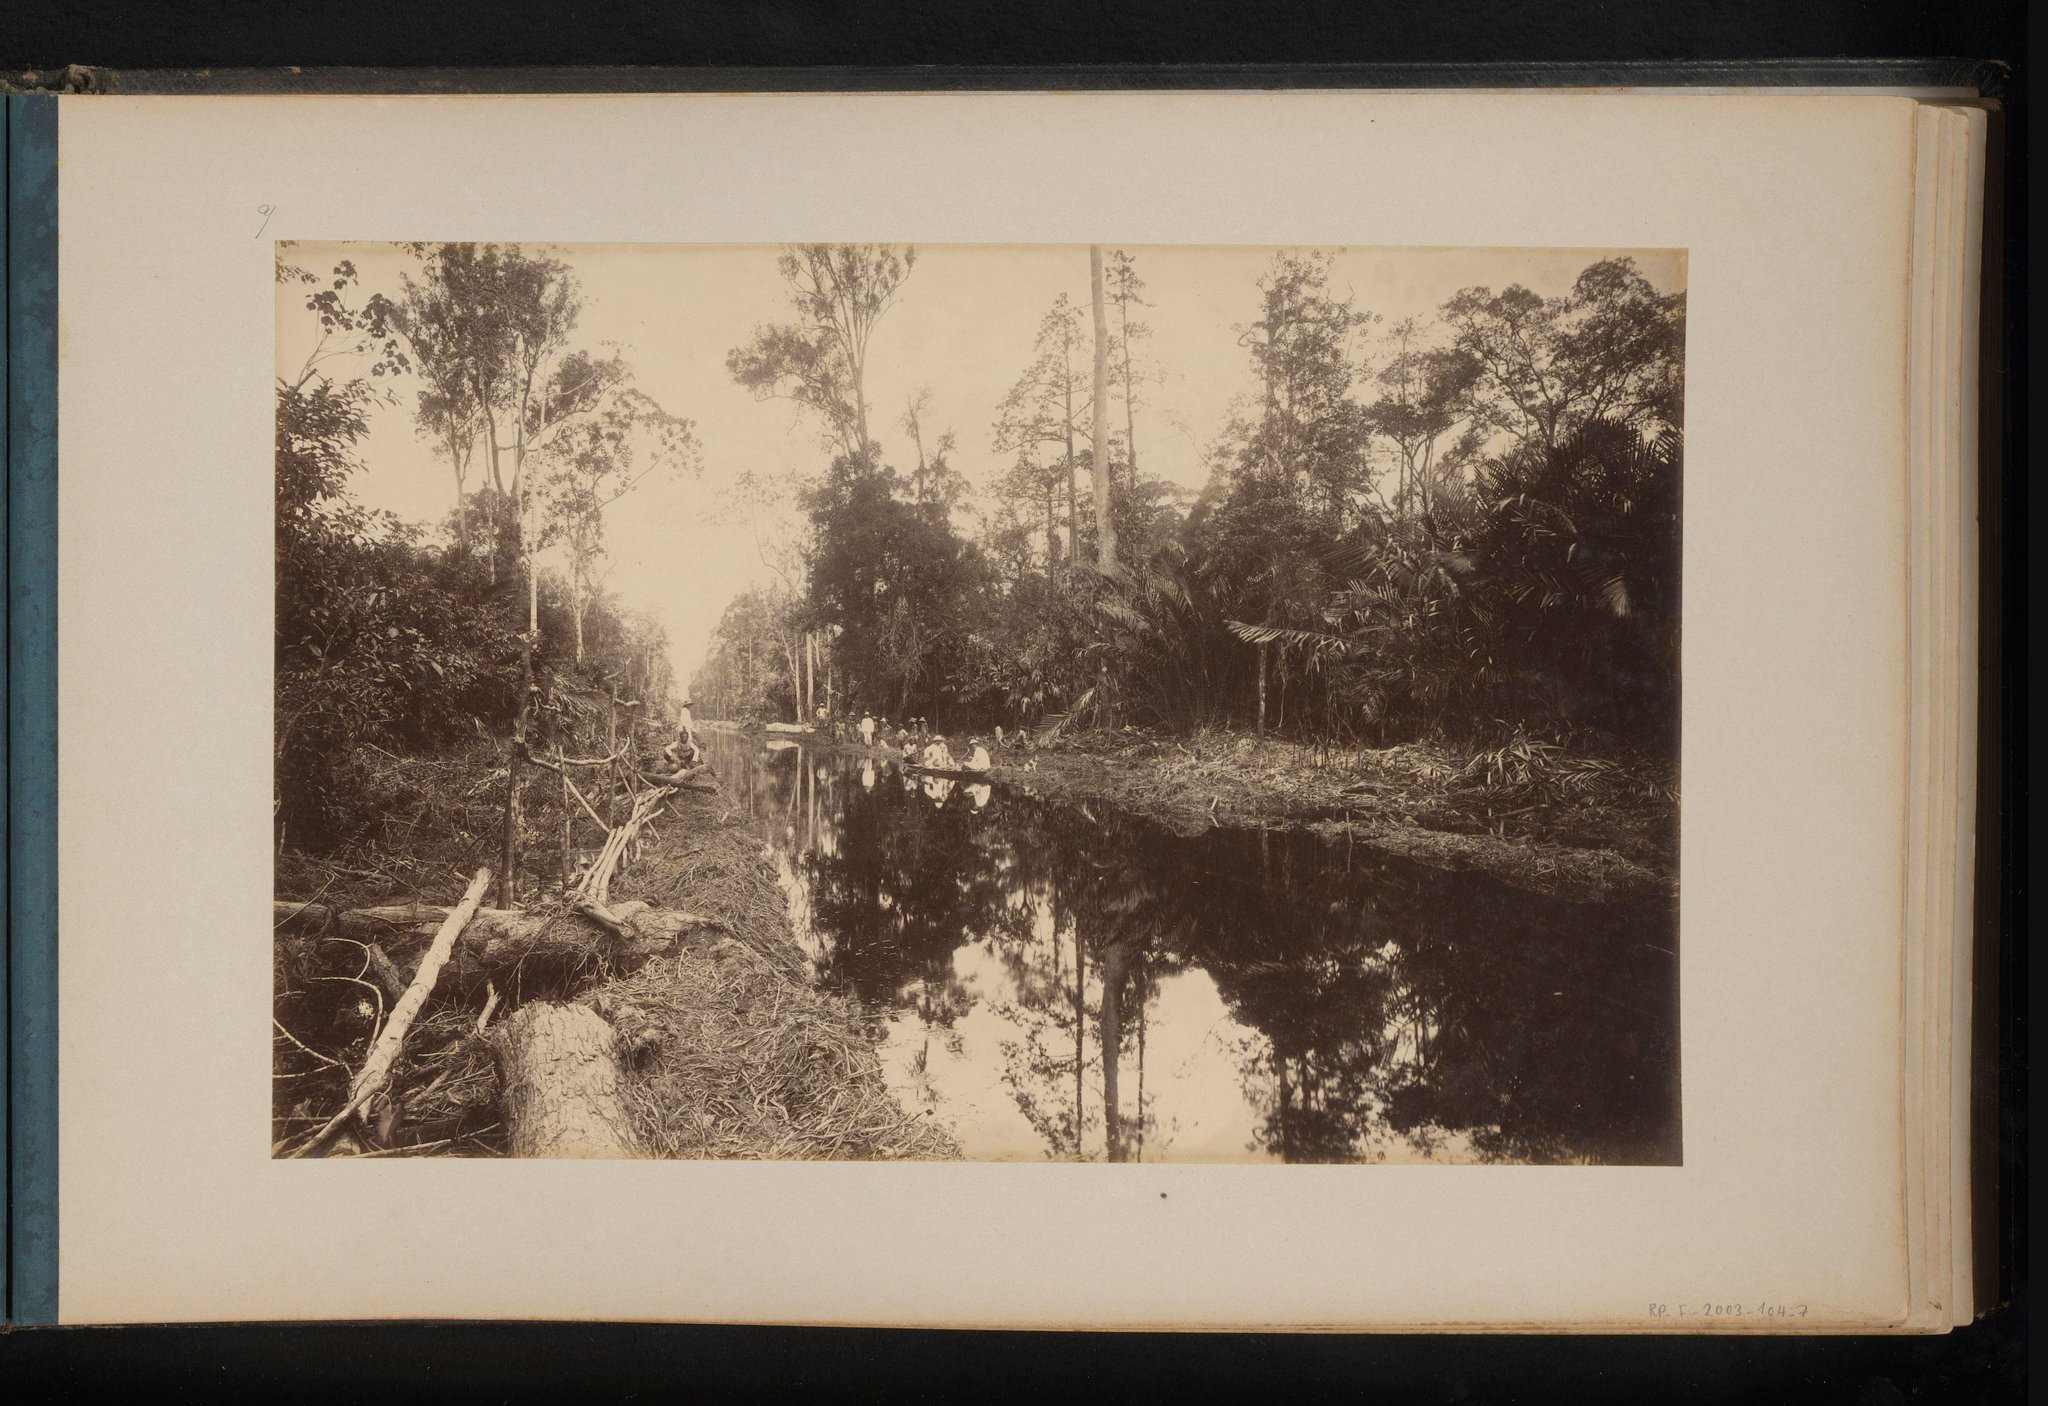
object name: album leaf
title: Kanaal in het oerwoud op de Stabat plantage, Sumatra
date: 1890-1900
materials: cardboard, photographic support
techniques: albumen print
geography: sumatra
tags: plantation, canal, working class, labourers, sumatra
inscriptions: number: ‘7’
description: In de lijst van afbeeldingen wordt deze foto beschreven met de woorden "Kanal durch Urwalt in Stabat-Estate".